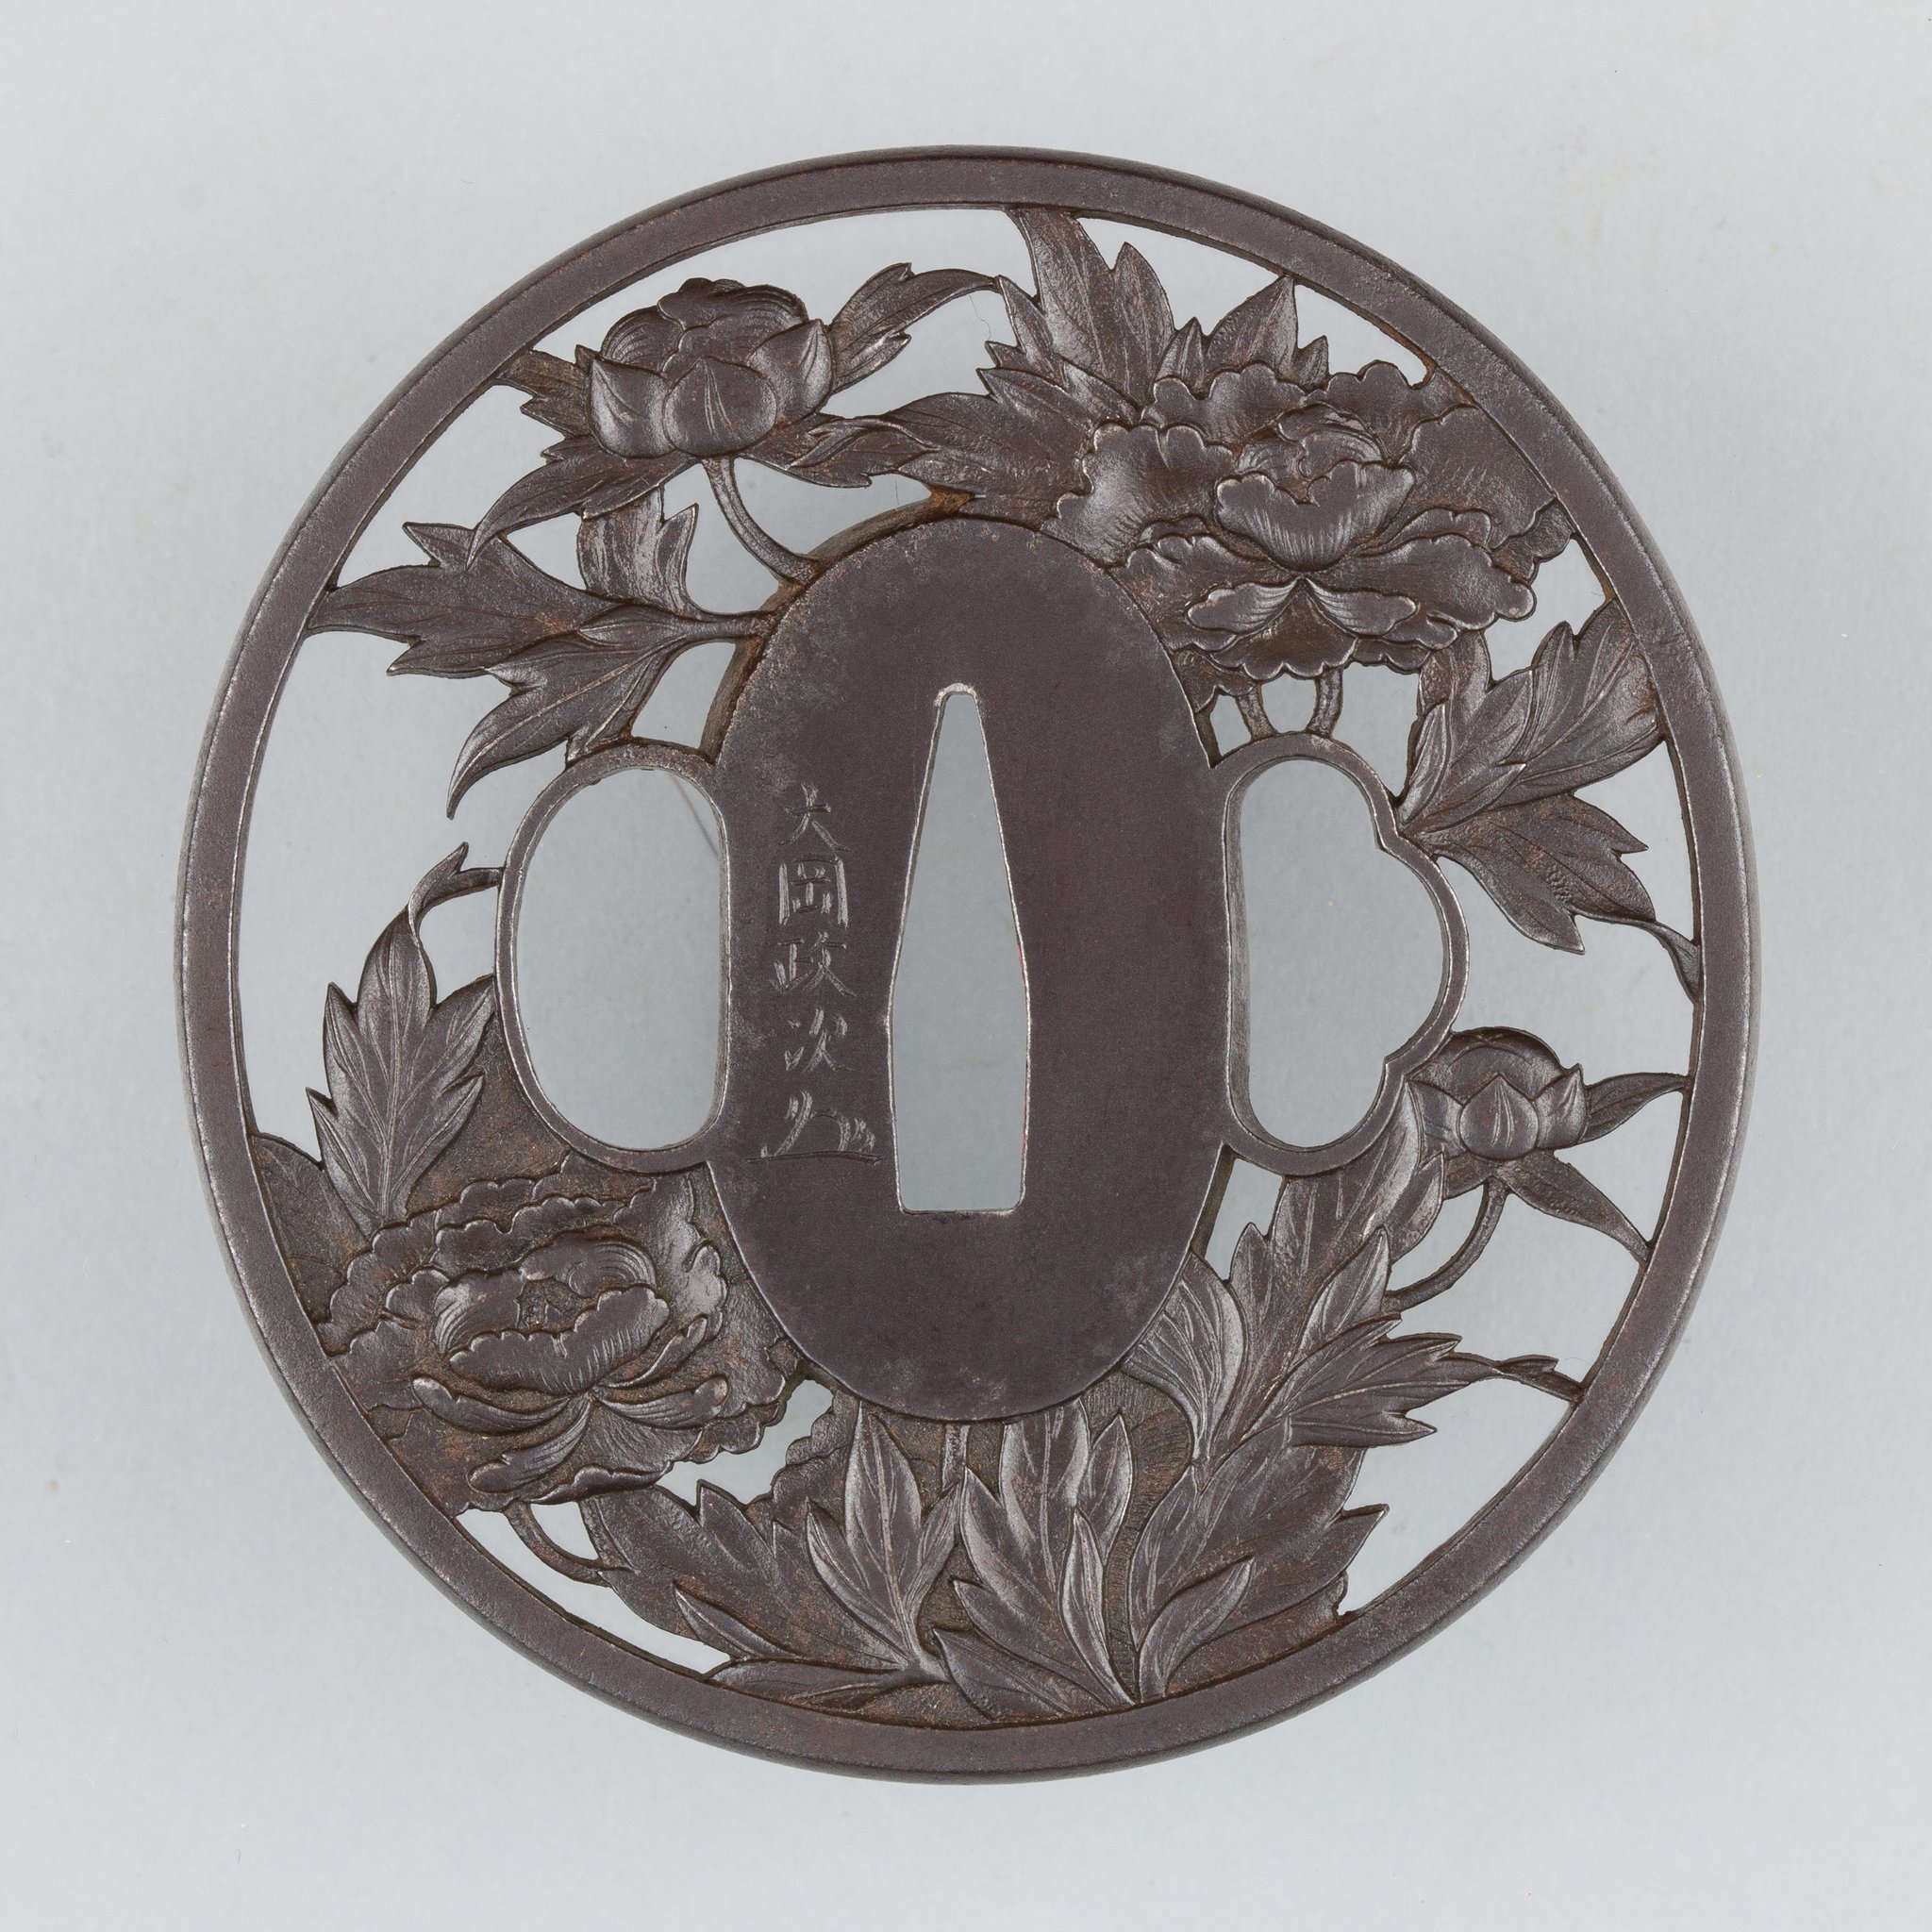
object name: sword guard tsuba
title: Sword Guard (Tsuba)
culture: japanese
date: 1701-1800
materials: copper, iron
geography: japan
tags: flowers